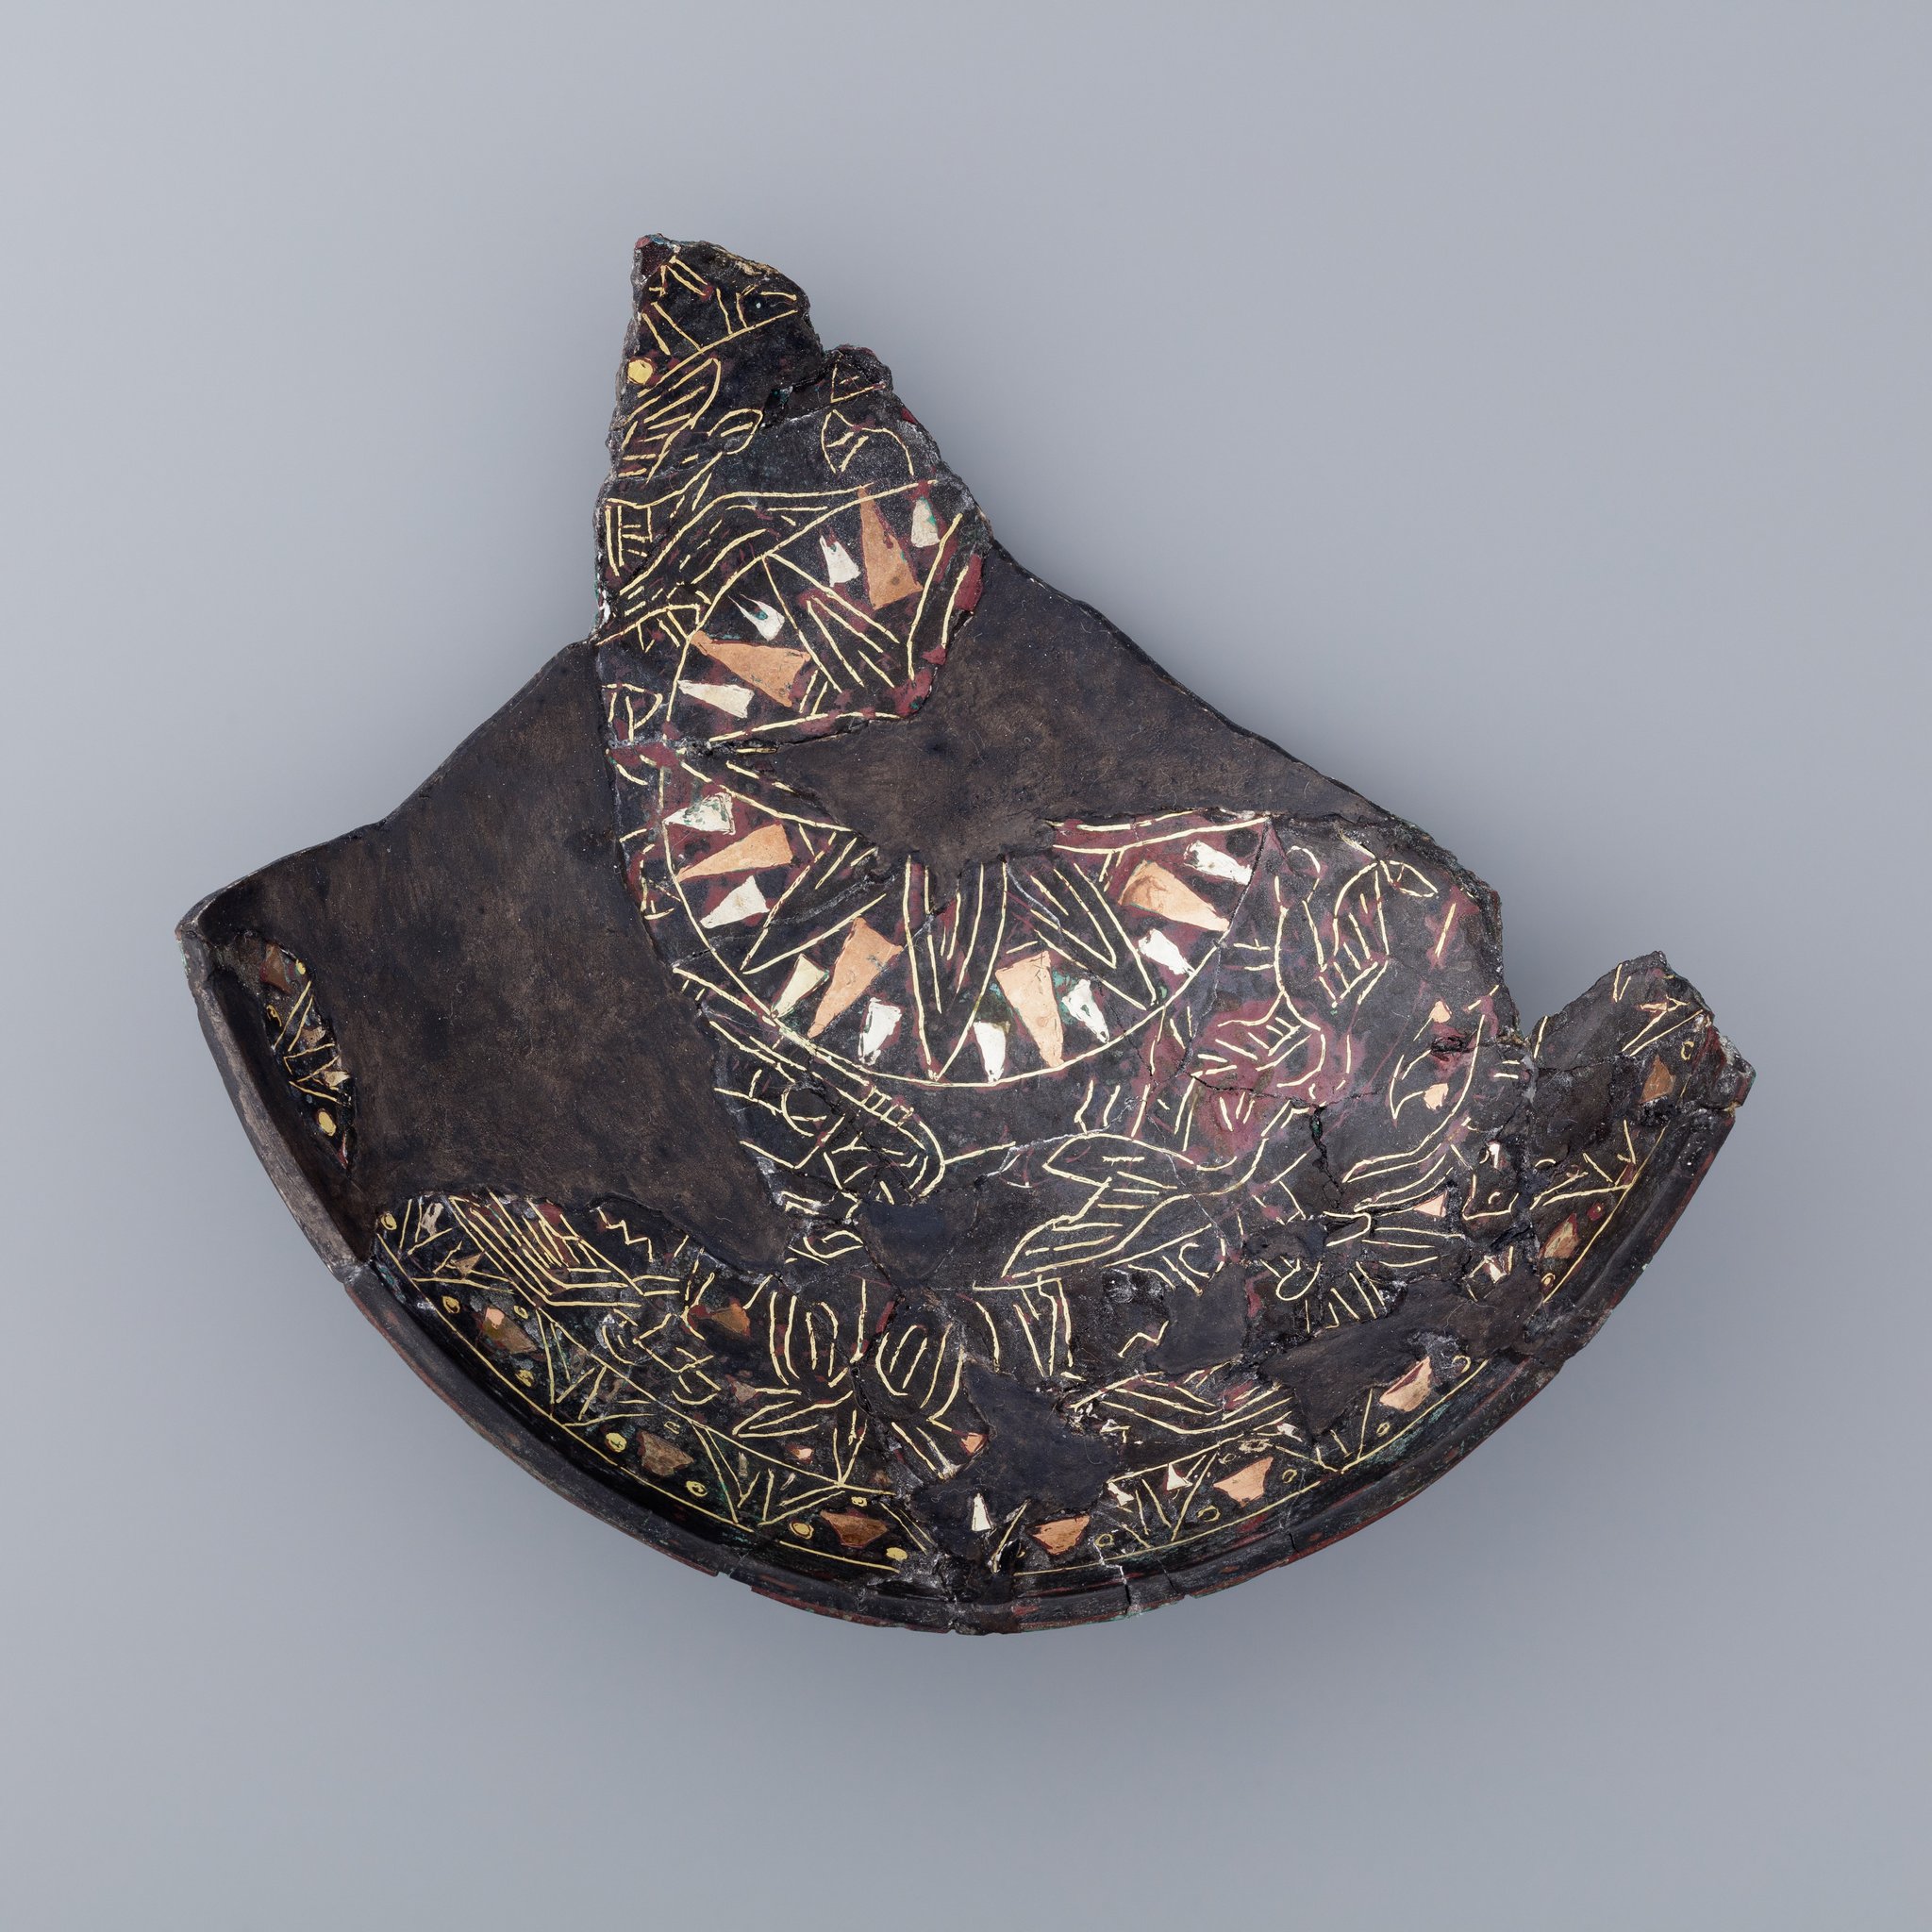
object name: bowl fragment, decorated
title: Fragment From Decorated Bowl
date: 1279-1213 BCE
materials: bronze, copper, gold, silver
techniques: inlay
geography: egypt